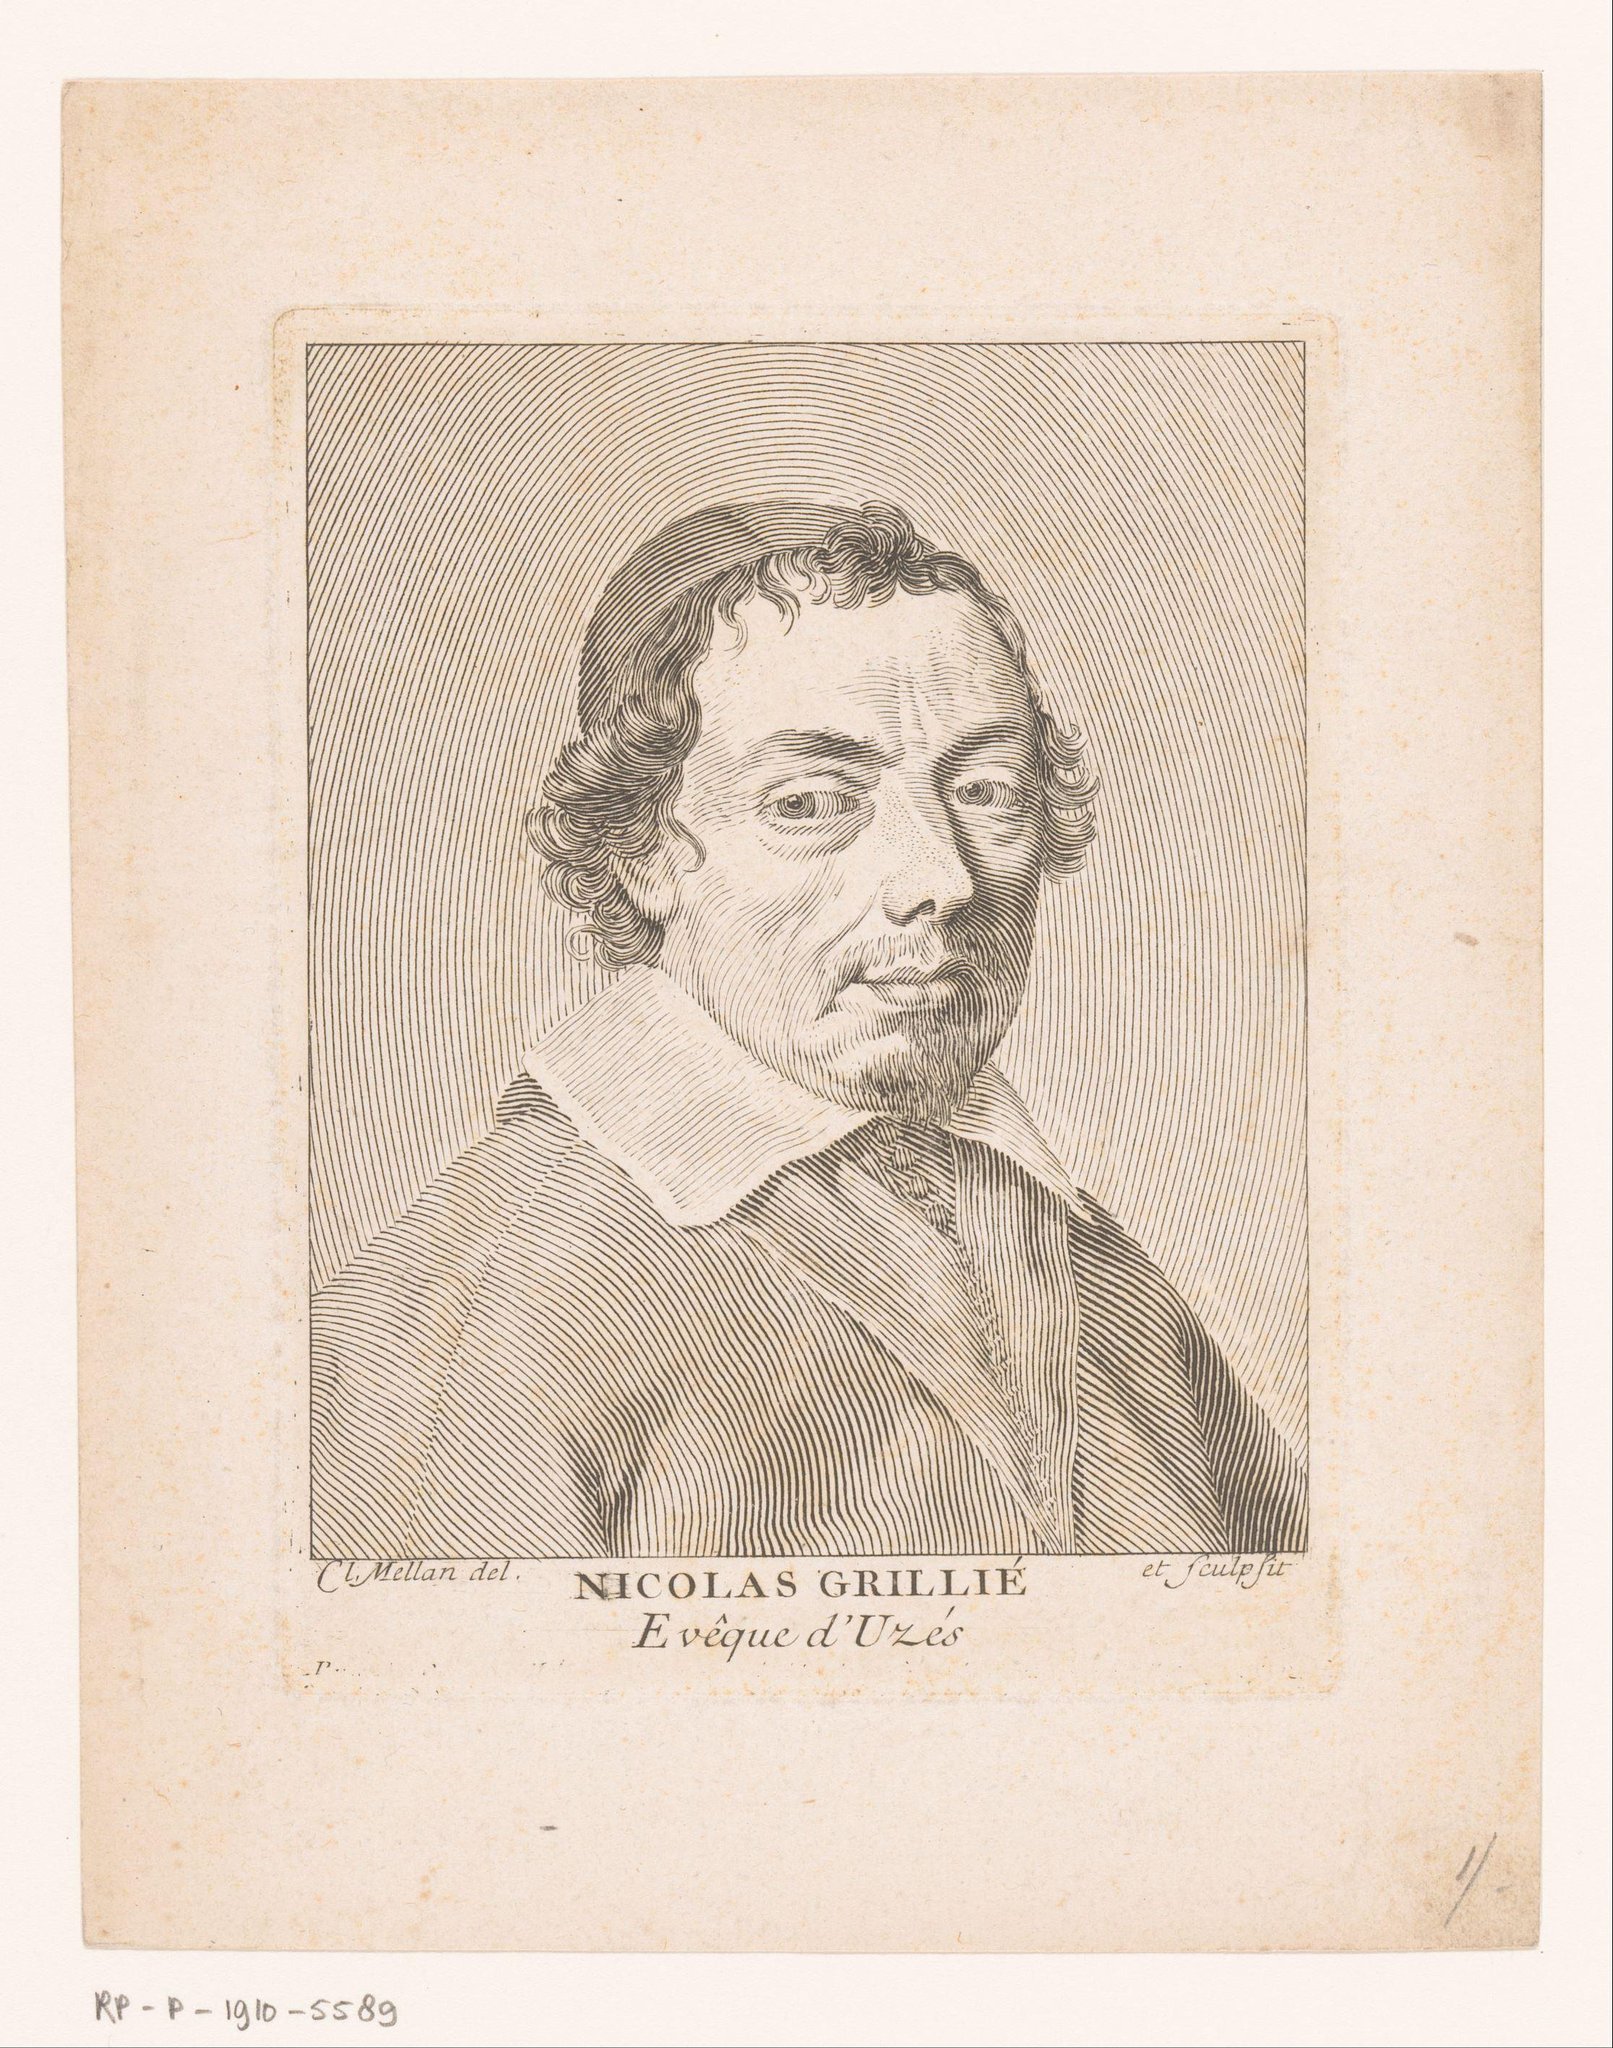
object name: print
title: Nicolas Grillié Evêque d'Uzés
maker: claude mellan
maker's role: draughtsman, print maker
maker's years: 1598-1688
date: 1633-1688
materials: paper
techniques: engraving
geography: france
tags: archbishop, bishop, etc. (roman catholic), historical persons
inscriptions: collector's mark: Lugt 2228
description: De voorbereidende tekening bevindt zich in de collectie van de Hermitage te Sint-Petersburg, inv.nr. 1826.